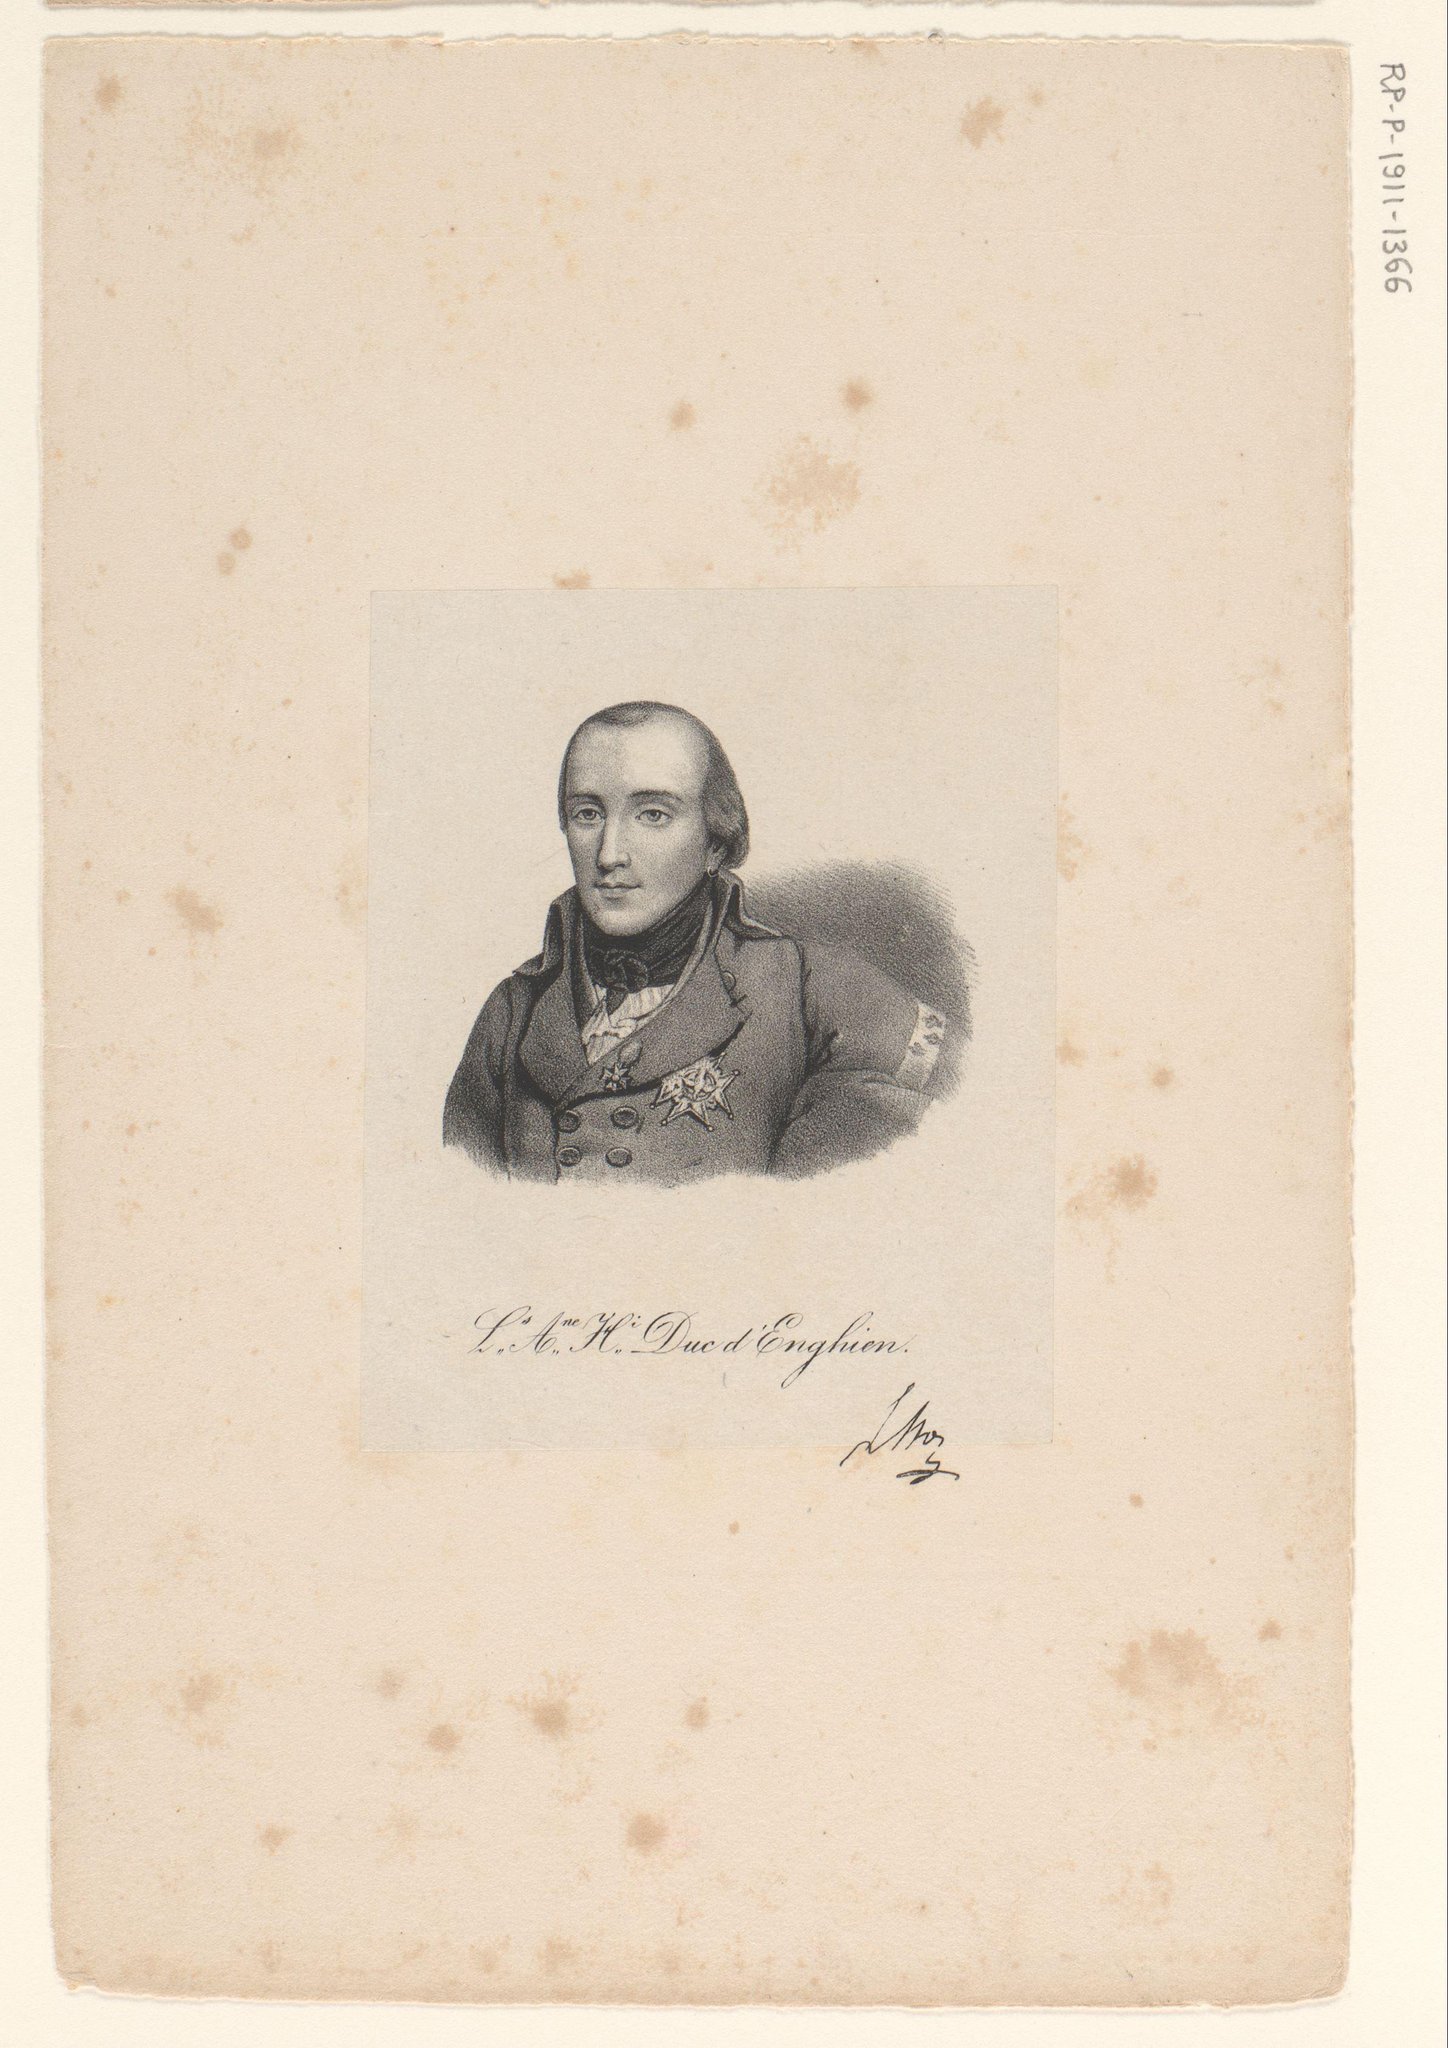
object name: print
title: Portret van Louis Antoine Henri de Bourbon-Condé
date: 1818-1842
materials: paper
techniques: lithograph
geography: paris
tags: chantilly, historical persons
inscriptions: collector's mark: Lugt 2228a